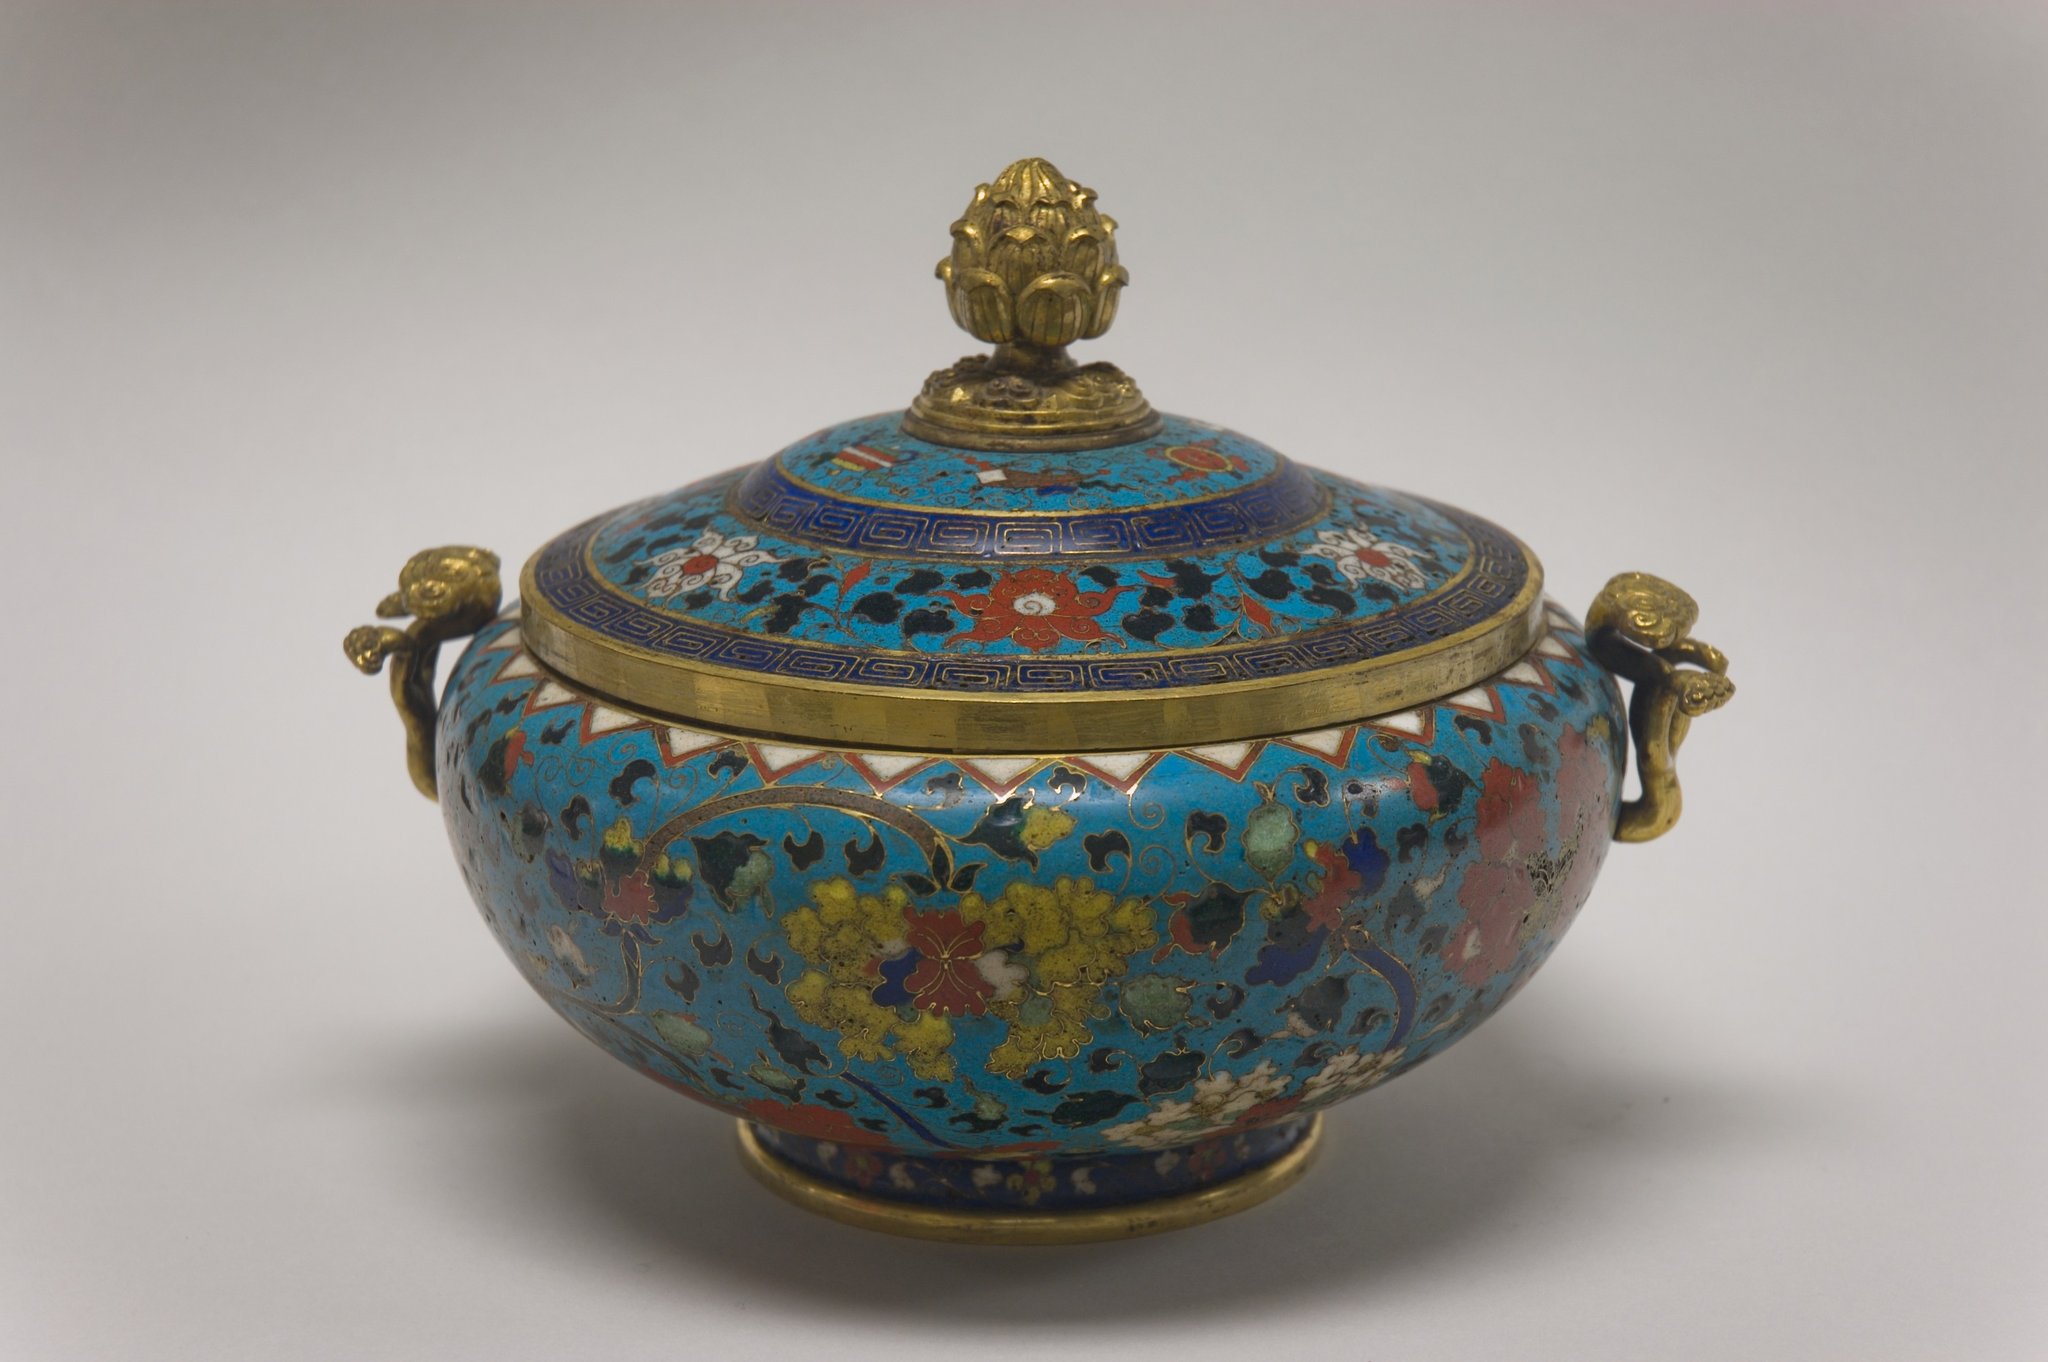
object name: covered bowl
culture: chinese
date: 1522-1566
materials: enamel, copper gilt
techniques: enamel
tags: flowers